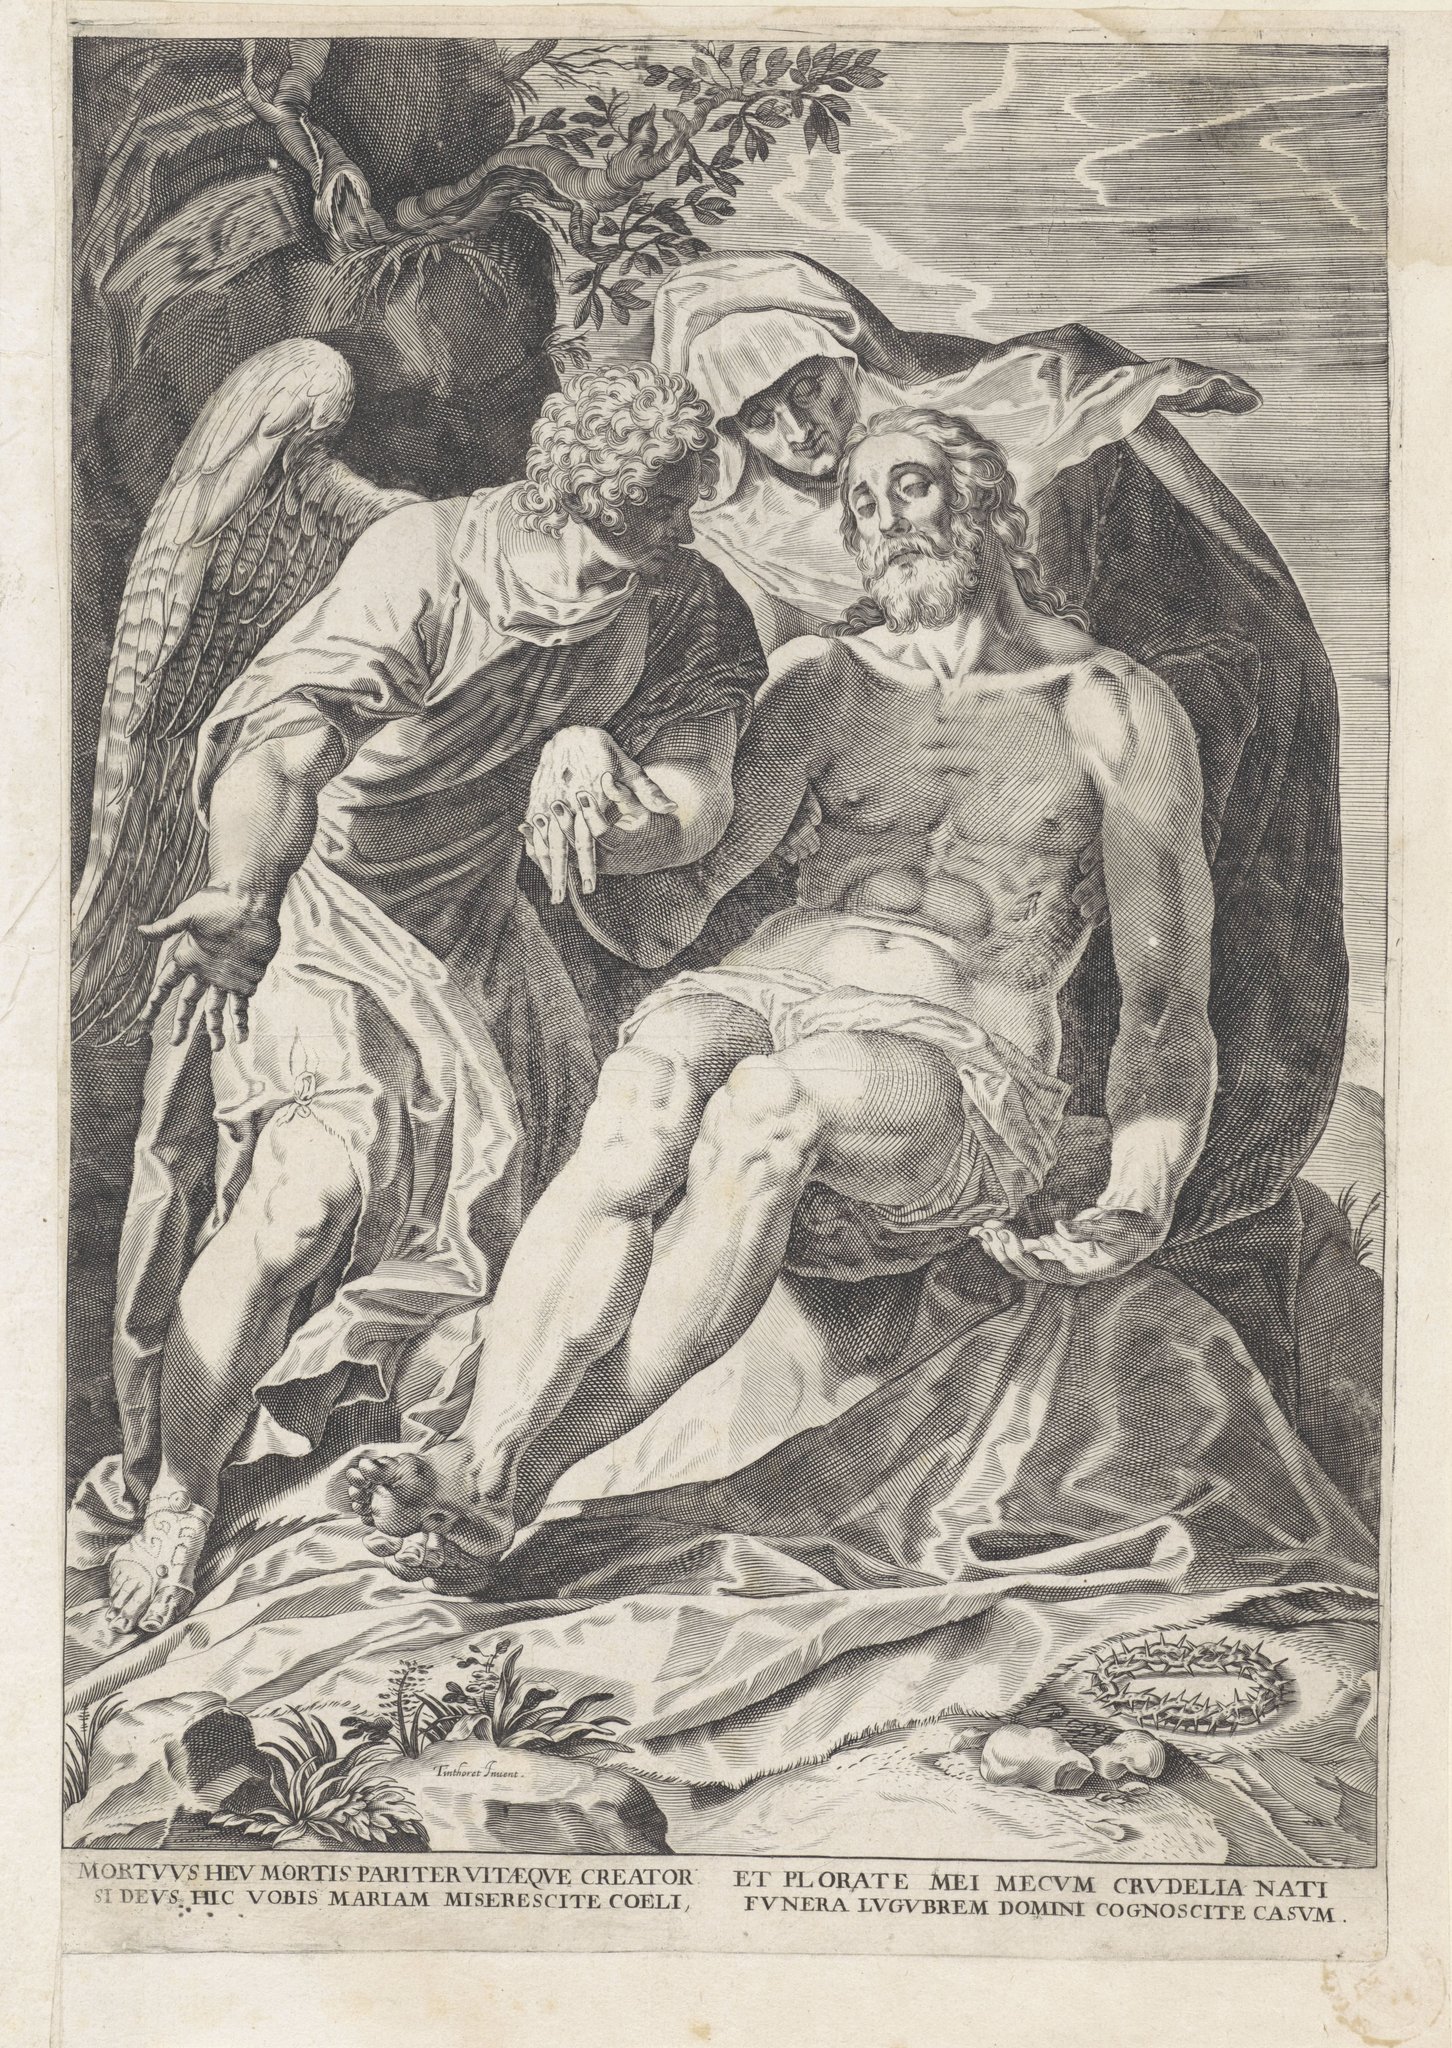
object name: print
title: Bewening van Christus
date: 1539-1644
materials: paper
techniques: engraving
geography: italy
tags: the mourning over the dead christ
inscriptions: collector's mark: Lugt 240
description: Maria ondersteunt het lichaam van Christus. Een engel houdt Christus' rechterhand vast. Rechtsvoor ligt de doornenkroon op de grond. Onder in de marge een vierregelig onderschrift in het Latijn.